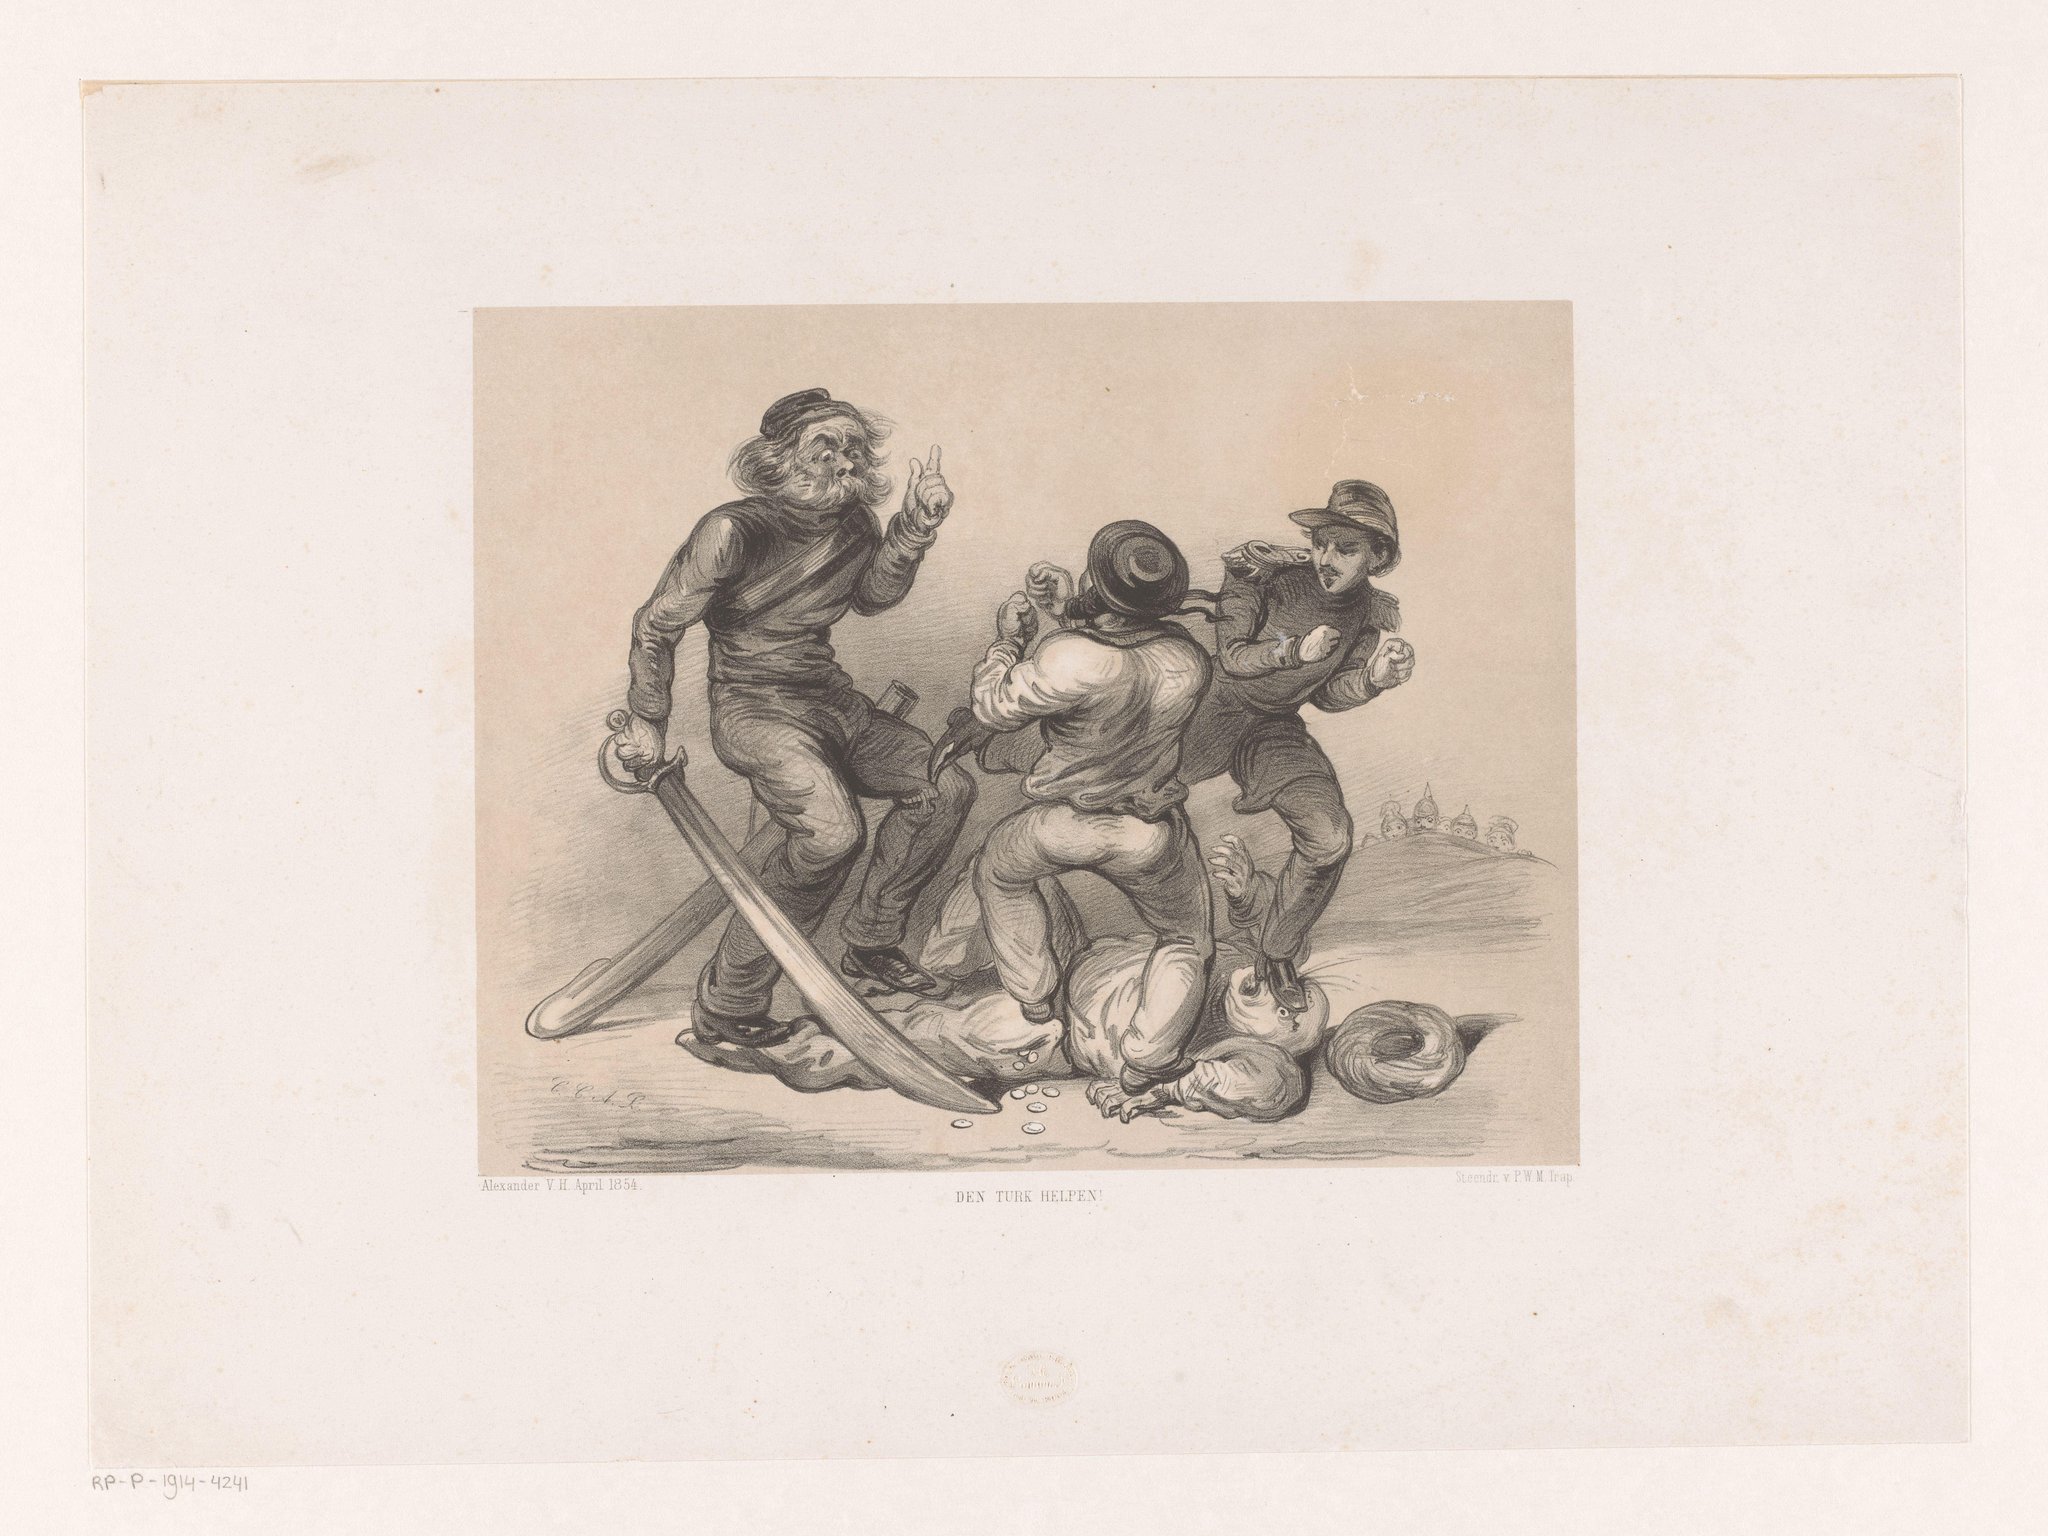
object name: print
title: Den Turk helpen!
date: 1854-1876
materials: paper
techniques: tone lithography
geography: amsterdam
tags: asiatic races and peoples: turks, fighting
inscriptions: check stamp: ‘Boek-papierhandel J.C. Loman Jr Amsterdam’, collector's mark: Lugt 2228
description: Twee mannen rechts houden hun gebalde vuisten omhoog, de man links wijst met zijn vinger omhoog en houdt een zwaard in zijn hand. Ondertussen vertrappen de drie mannen een Turkse man met tulband.